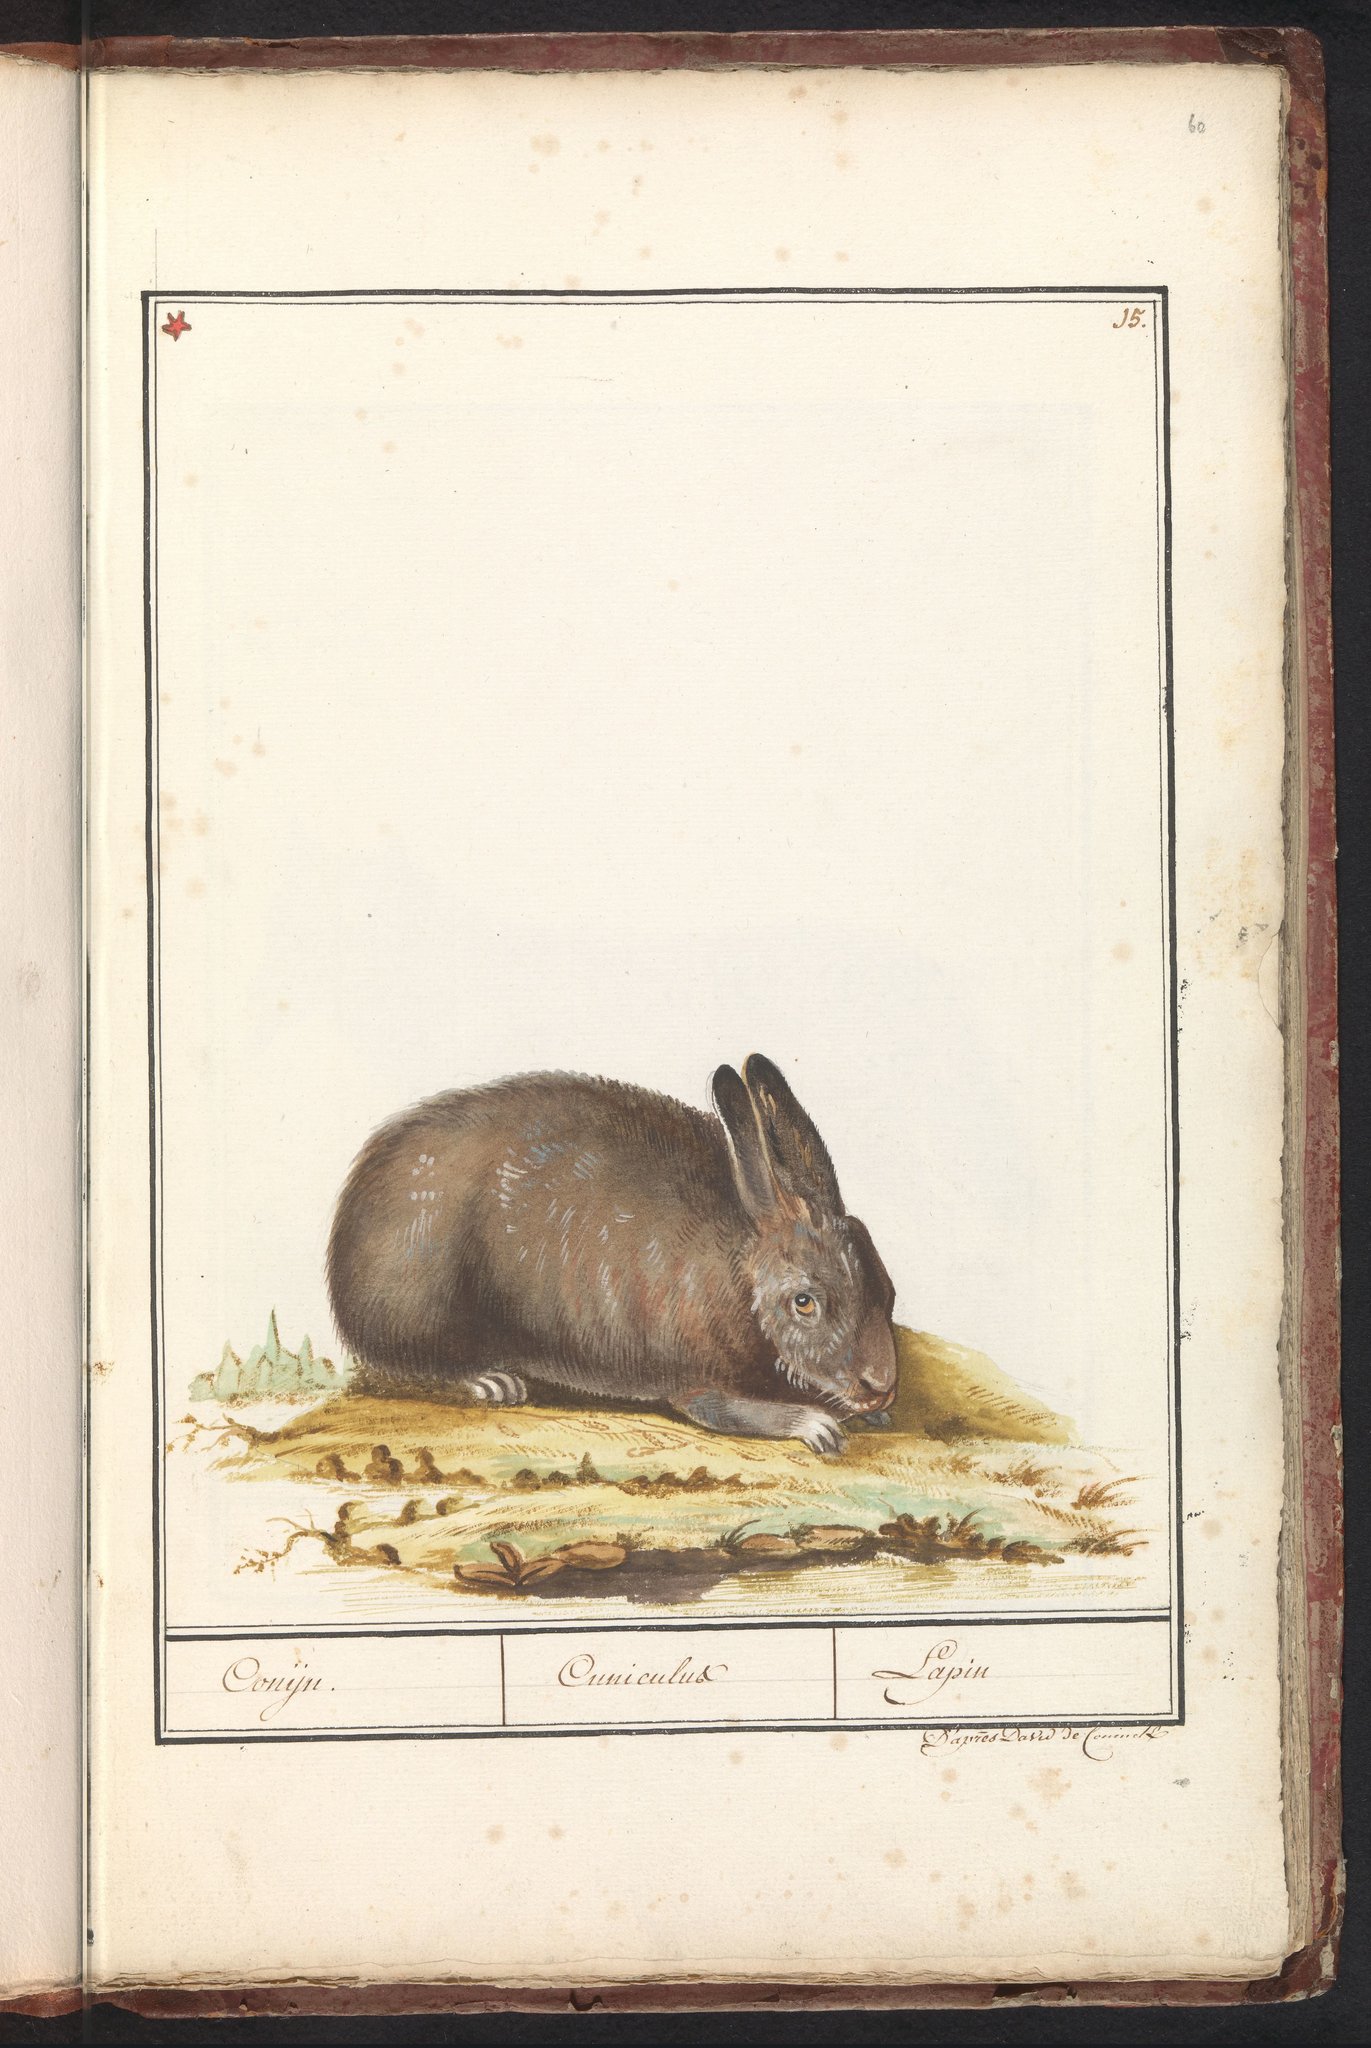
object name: drawing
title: Konijn (Oryctolagus cuniculus)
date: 1790-1814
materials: chalk, paint, paper, watercolor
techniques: brush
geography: southern netherlands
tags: rodents: rabbit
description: Konijn. Rechtsboven genummerd: 15. Linksboven gemerkt met een rood sterretje. Onderdeel van het eerste album met tekeningen van viervoeters. Eerste van twaalf albums met tekeningen van dieren, vogels en planten bekend rond 1600, gemaakt in opdracht van keizer Rudolf II. Met toelichting in Nederlands, Latijn en Frans.